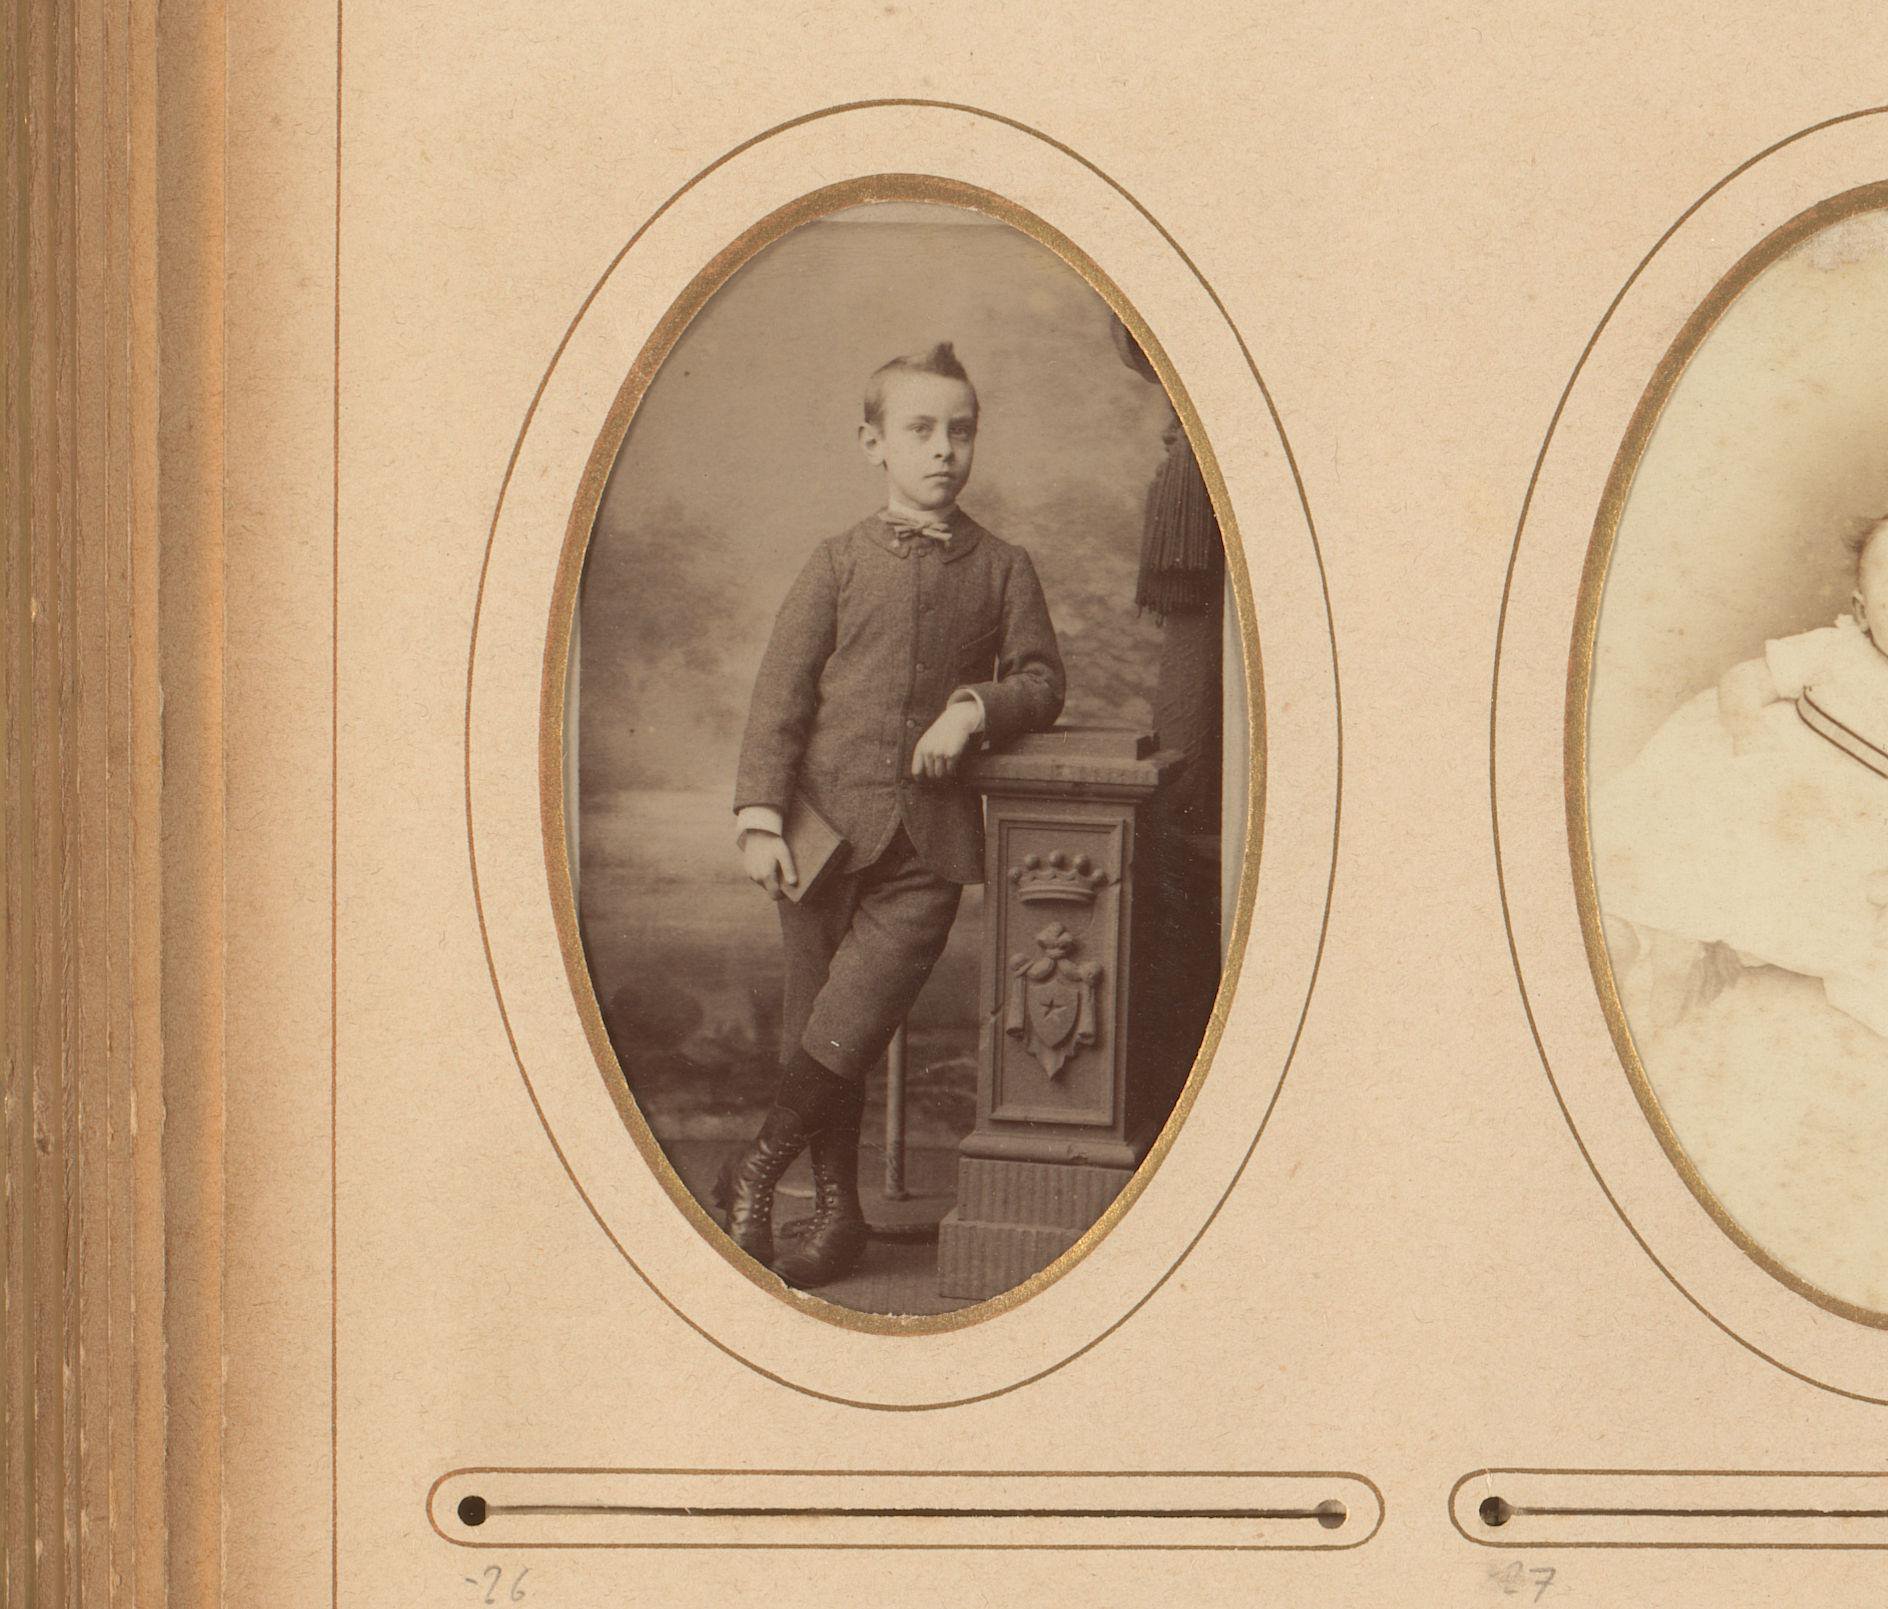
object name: photograph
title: Portret van een onbekende jongen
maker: Anonymous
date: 1880-1890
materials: paper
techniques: albumen print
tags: anonymous historical person portrayed